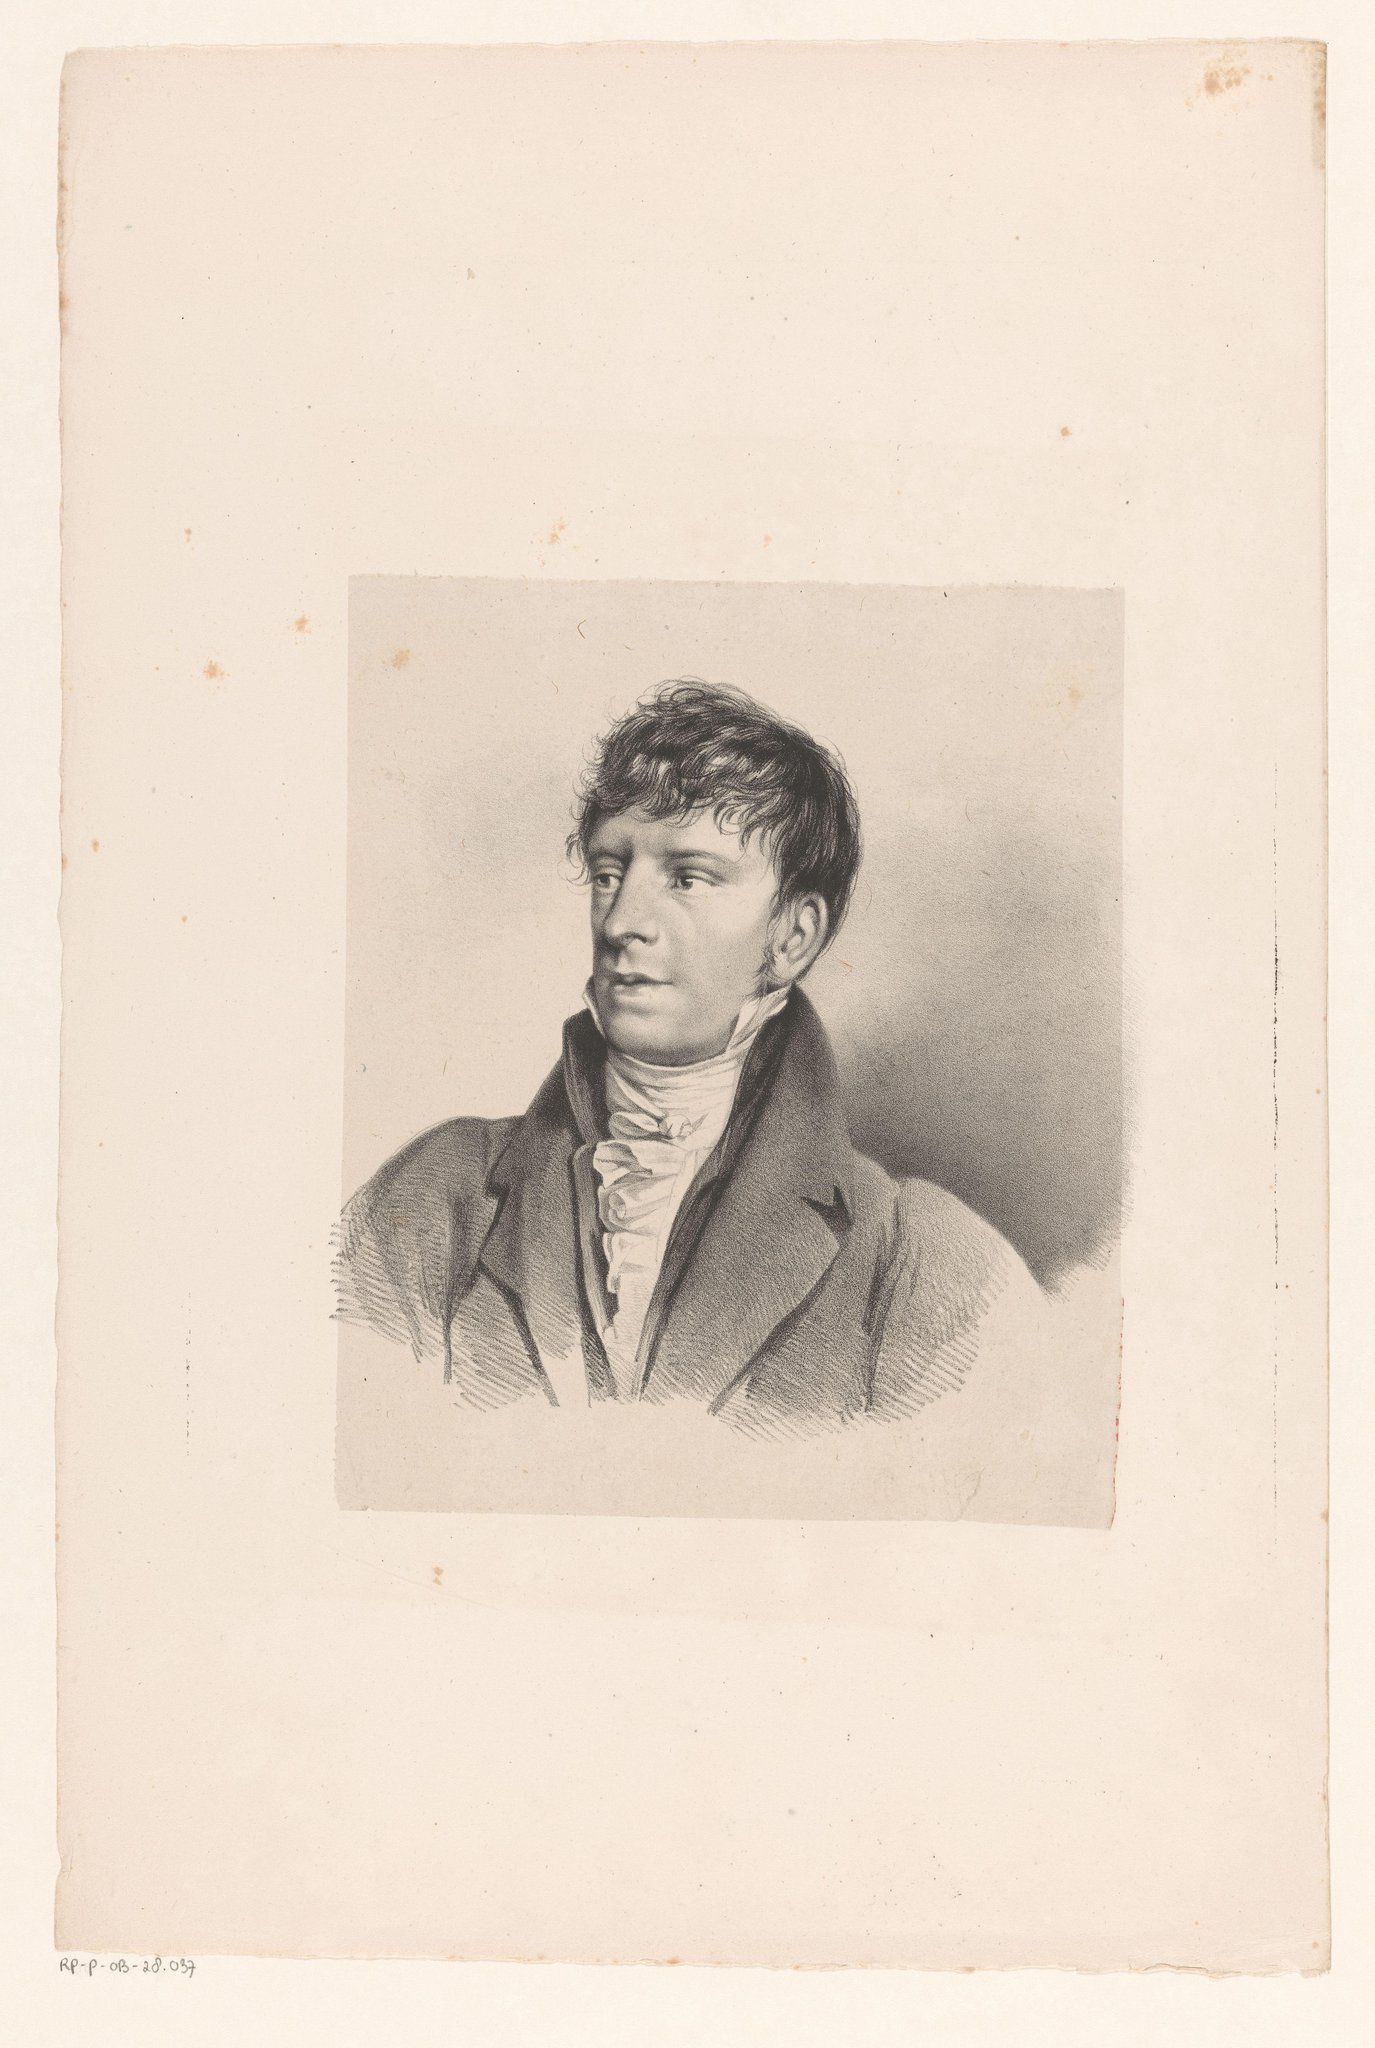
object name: print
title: Portret van Jan Hulswit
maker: jean augustin daiwaille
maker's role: draughtsman, print maker, printer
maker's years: 1786-1850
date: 1809-1850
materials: paper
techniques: lithograph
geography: amsterdam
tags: painter, draughtsman, jan hulswit, historical persons (+ head (and shoulders) (portrait))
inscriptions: collector's mark: Lugt 2228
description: De geportretteerde kijkt naar links. Hij draagt een jas met een opstaande kraag en een wit overhem met geplooide kraag.